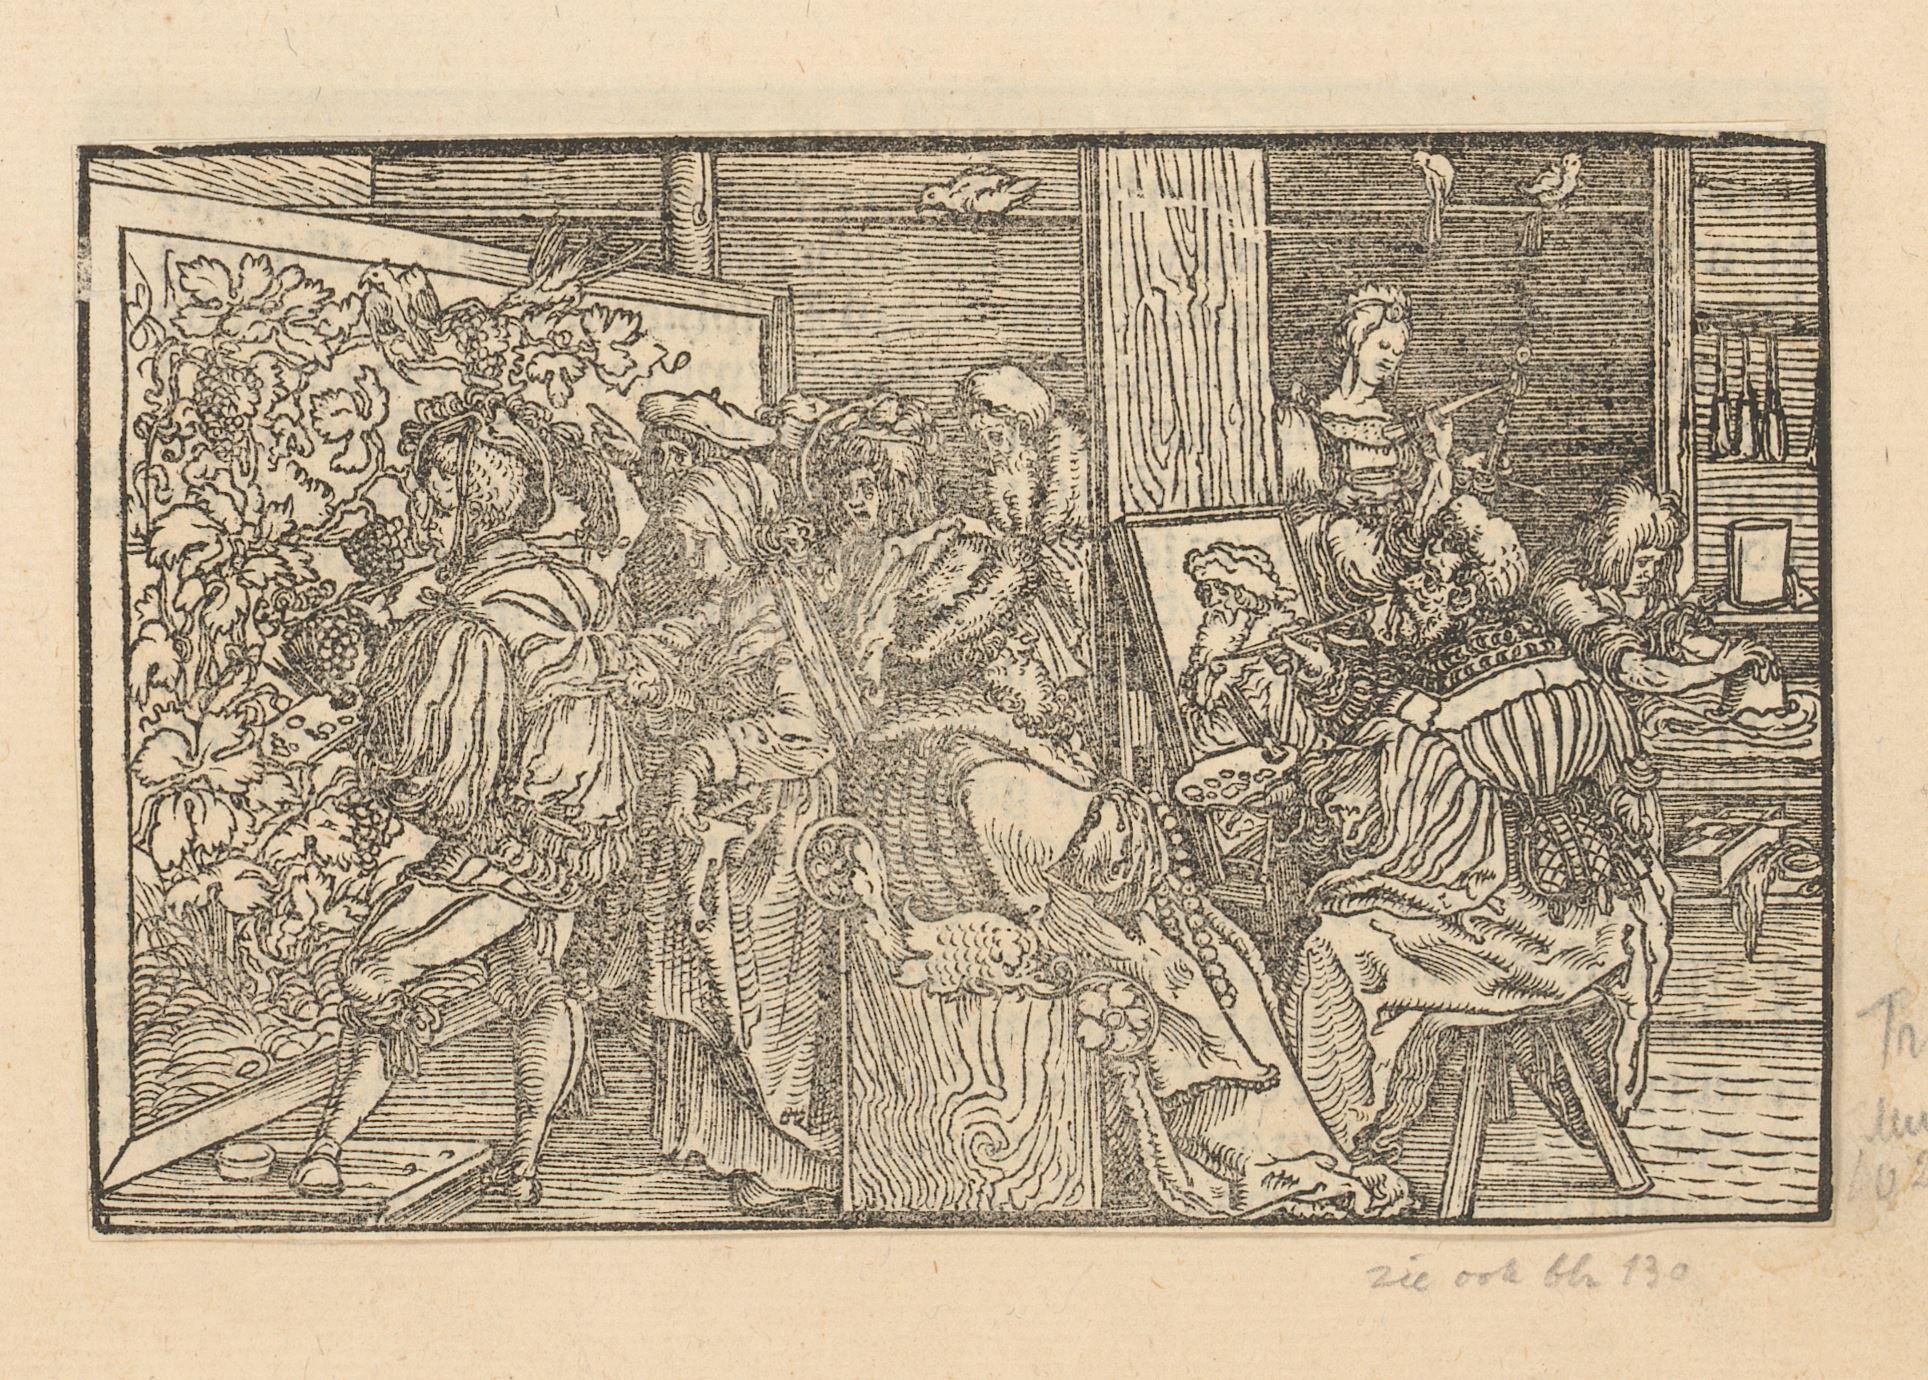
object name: book illustration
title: Kunstenaars in een atelier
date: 1514-1532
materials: paper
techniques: letterpress printing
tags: workshop, studio of the artist (in general)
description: Deze prent is gebruikt in: Petrarca, Francesco. Von der Artzney bayder Glück, des guten und widerwertigen: unnd weß sich ain yeder inn Gelück und Unglück halten sol (...). Augsburg: Heinrich Steiner, 1532. Deze uitgave is ook bekend onder de titel 'Trostspiegel in Glück und Unglück'. Deze prent is ook gebruikt in: Cicero, Marcus Tulius. Officia M.T.C. Ein Buch so Marcus Tullius Cicero der Römer zu seynem (...). [Vertaald uit het Latijn door] Johann von Schwarzenberg. Augsburg: Heinrich Steiner, 1531.